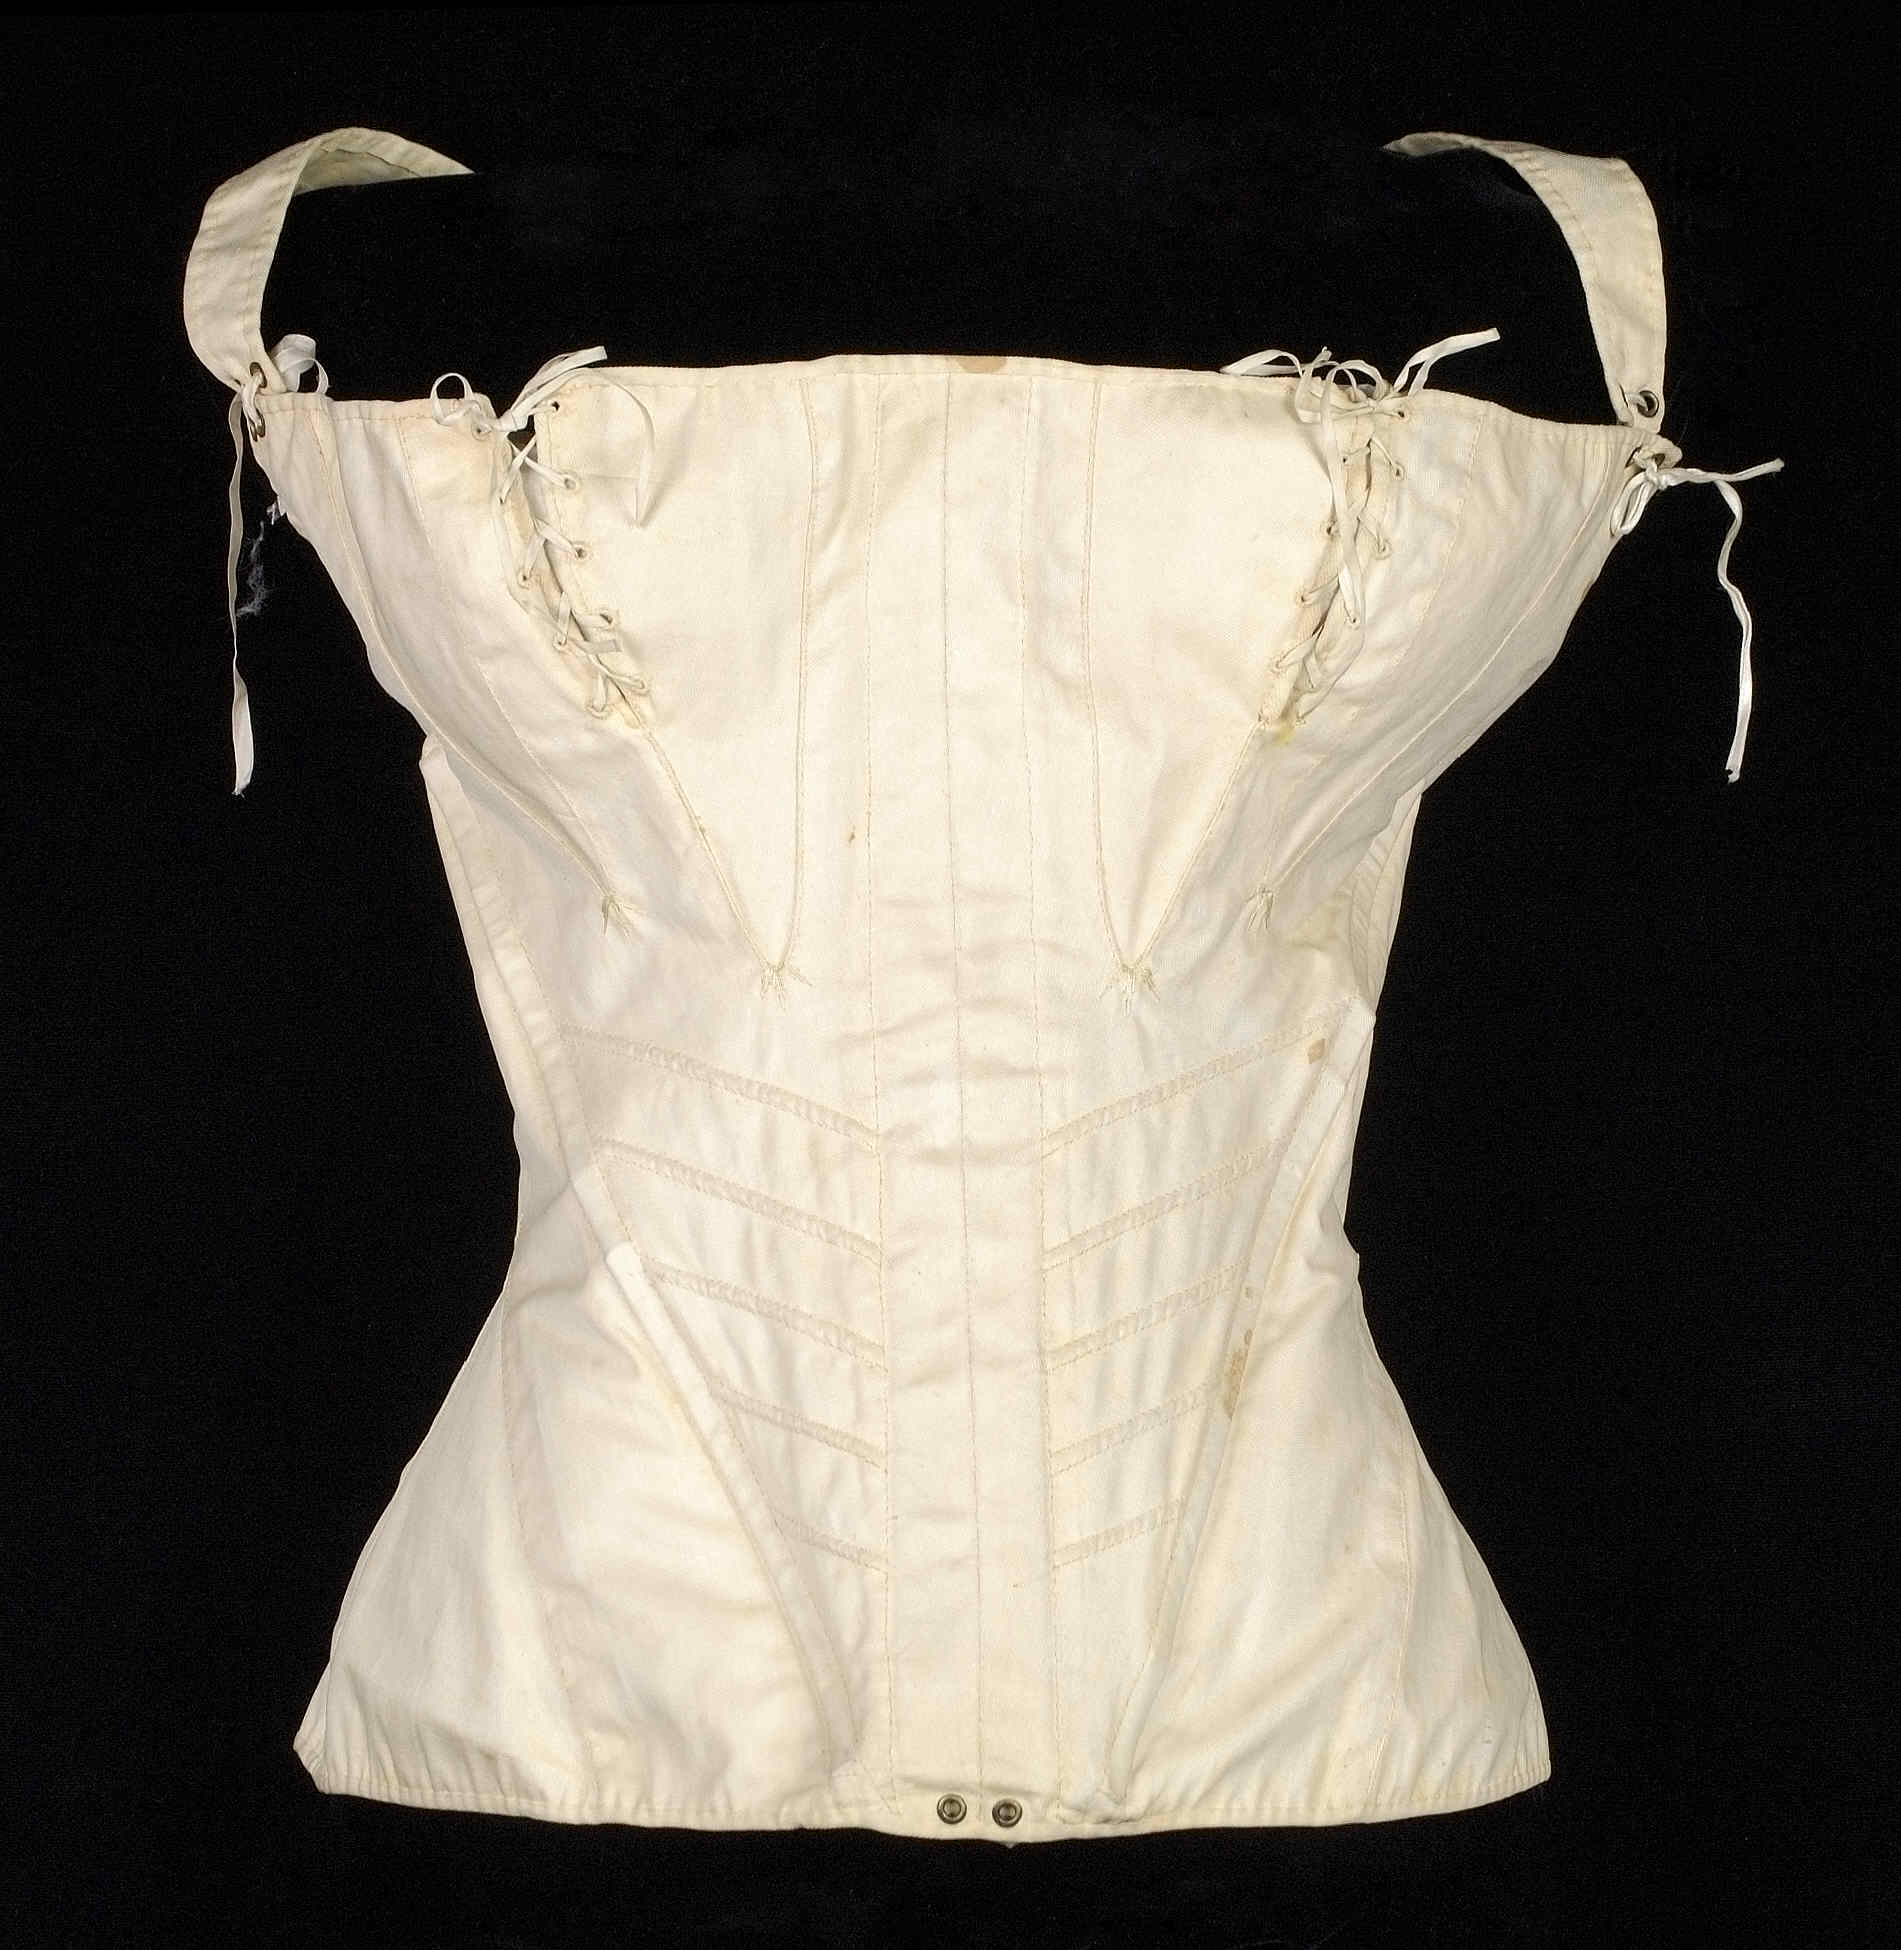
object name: stay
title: Stays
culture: american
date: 1835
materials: bone, cotton, metal